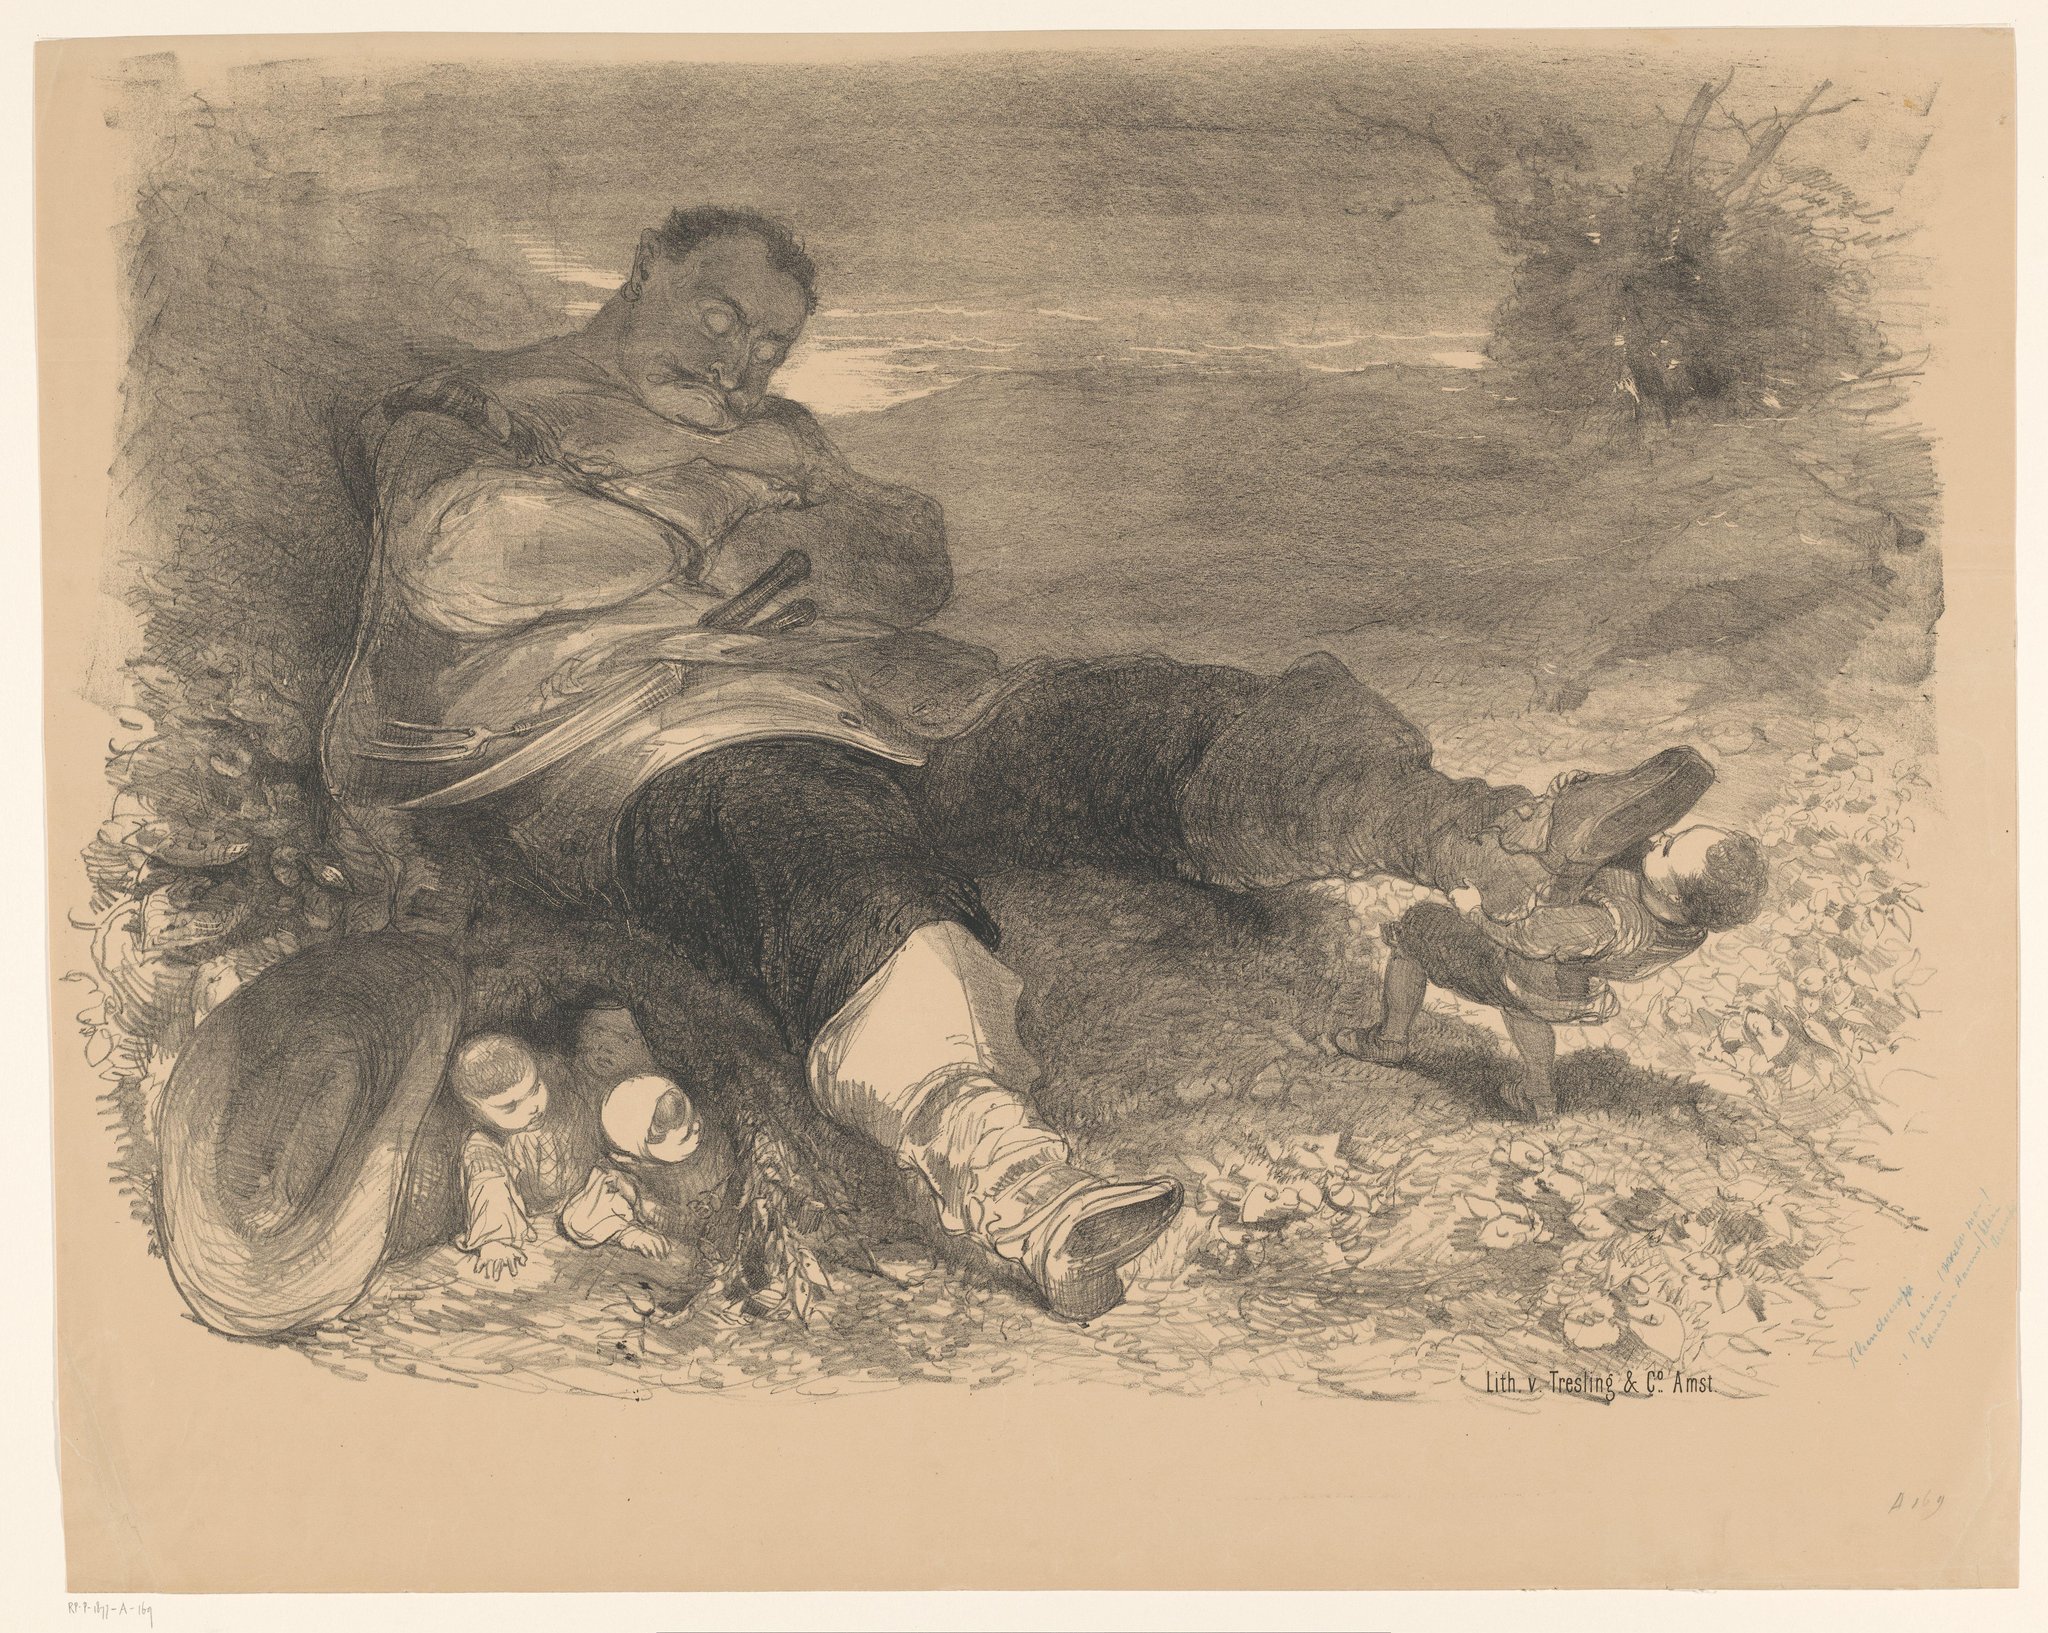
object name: print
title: Aankondigingsbiljetten van balletten en toneelstukken opgevoerd in de Amsterdamse Stadsschouwburg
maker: charles rochussen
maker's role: draughtsman, painter, print maker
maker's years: 1814-1894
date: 1865-1868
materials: paper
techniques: lithograph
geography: netherlands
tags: theatre, theatrical performance, tales and fairy tales: little thumbling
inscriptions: inscription: ‘Kleinduimpje / Beckman / (...) / Eduard van Hamme / klein Duimpje’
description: Klein Duimpje berooft de reus van zijn zeven mijlslaarzen zodat hij later samen met broers en zussen kan vluchten.